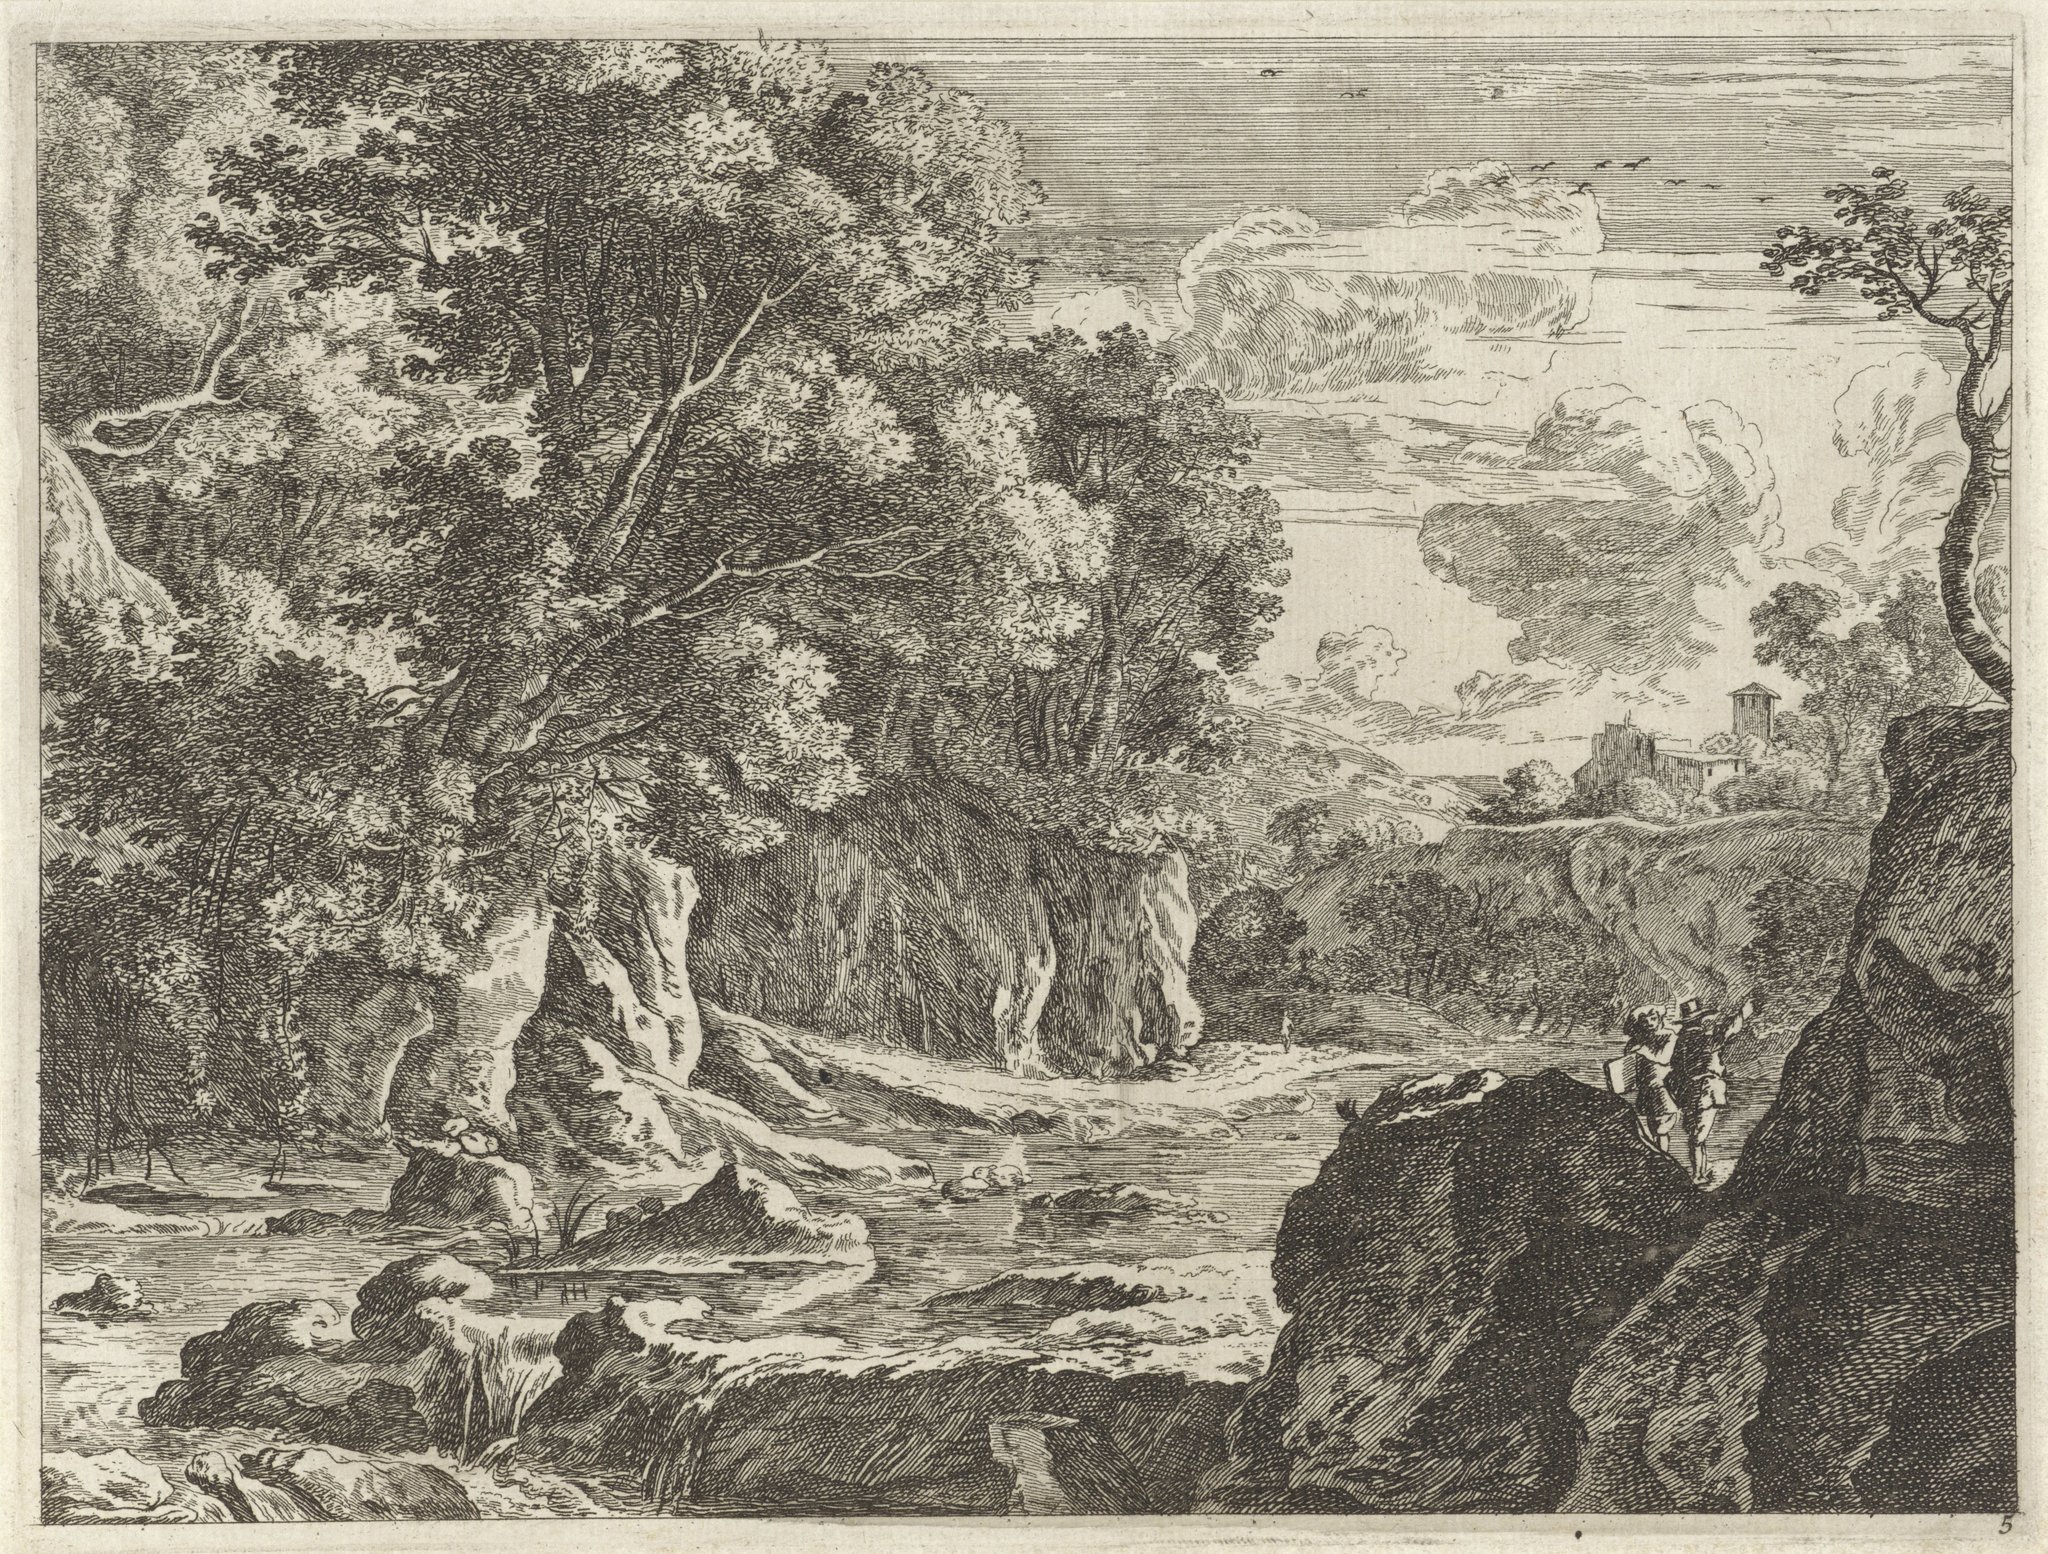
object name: print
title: Rivierlandschap met twee figuren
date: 1643-1679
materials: paper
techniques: etching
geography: amsterdam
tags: river, rural housing, e.g. country-house, villa, cottage, draughtsman at work - cc - out of doors, rocks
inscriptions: collector's mark: Lugt 240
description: Twee figuren staan op een rots bij een rivier.